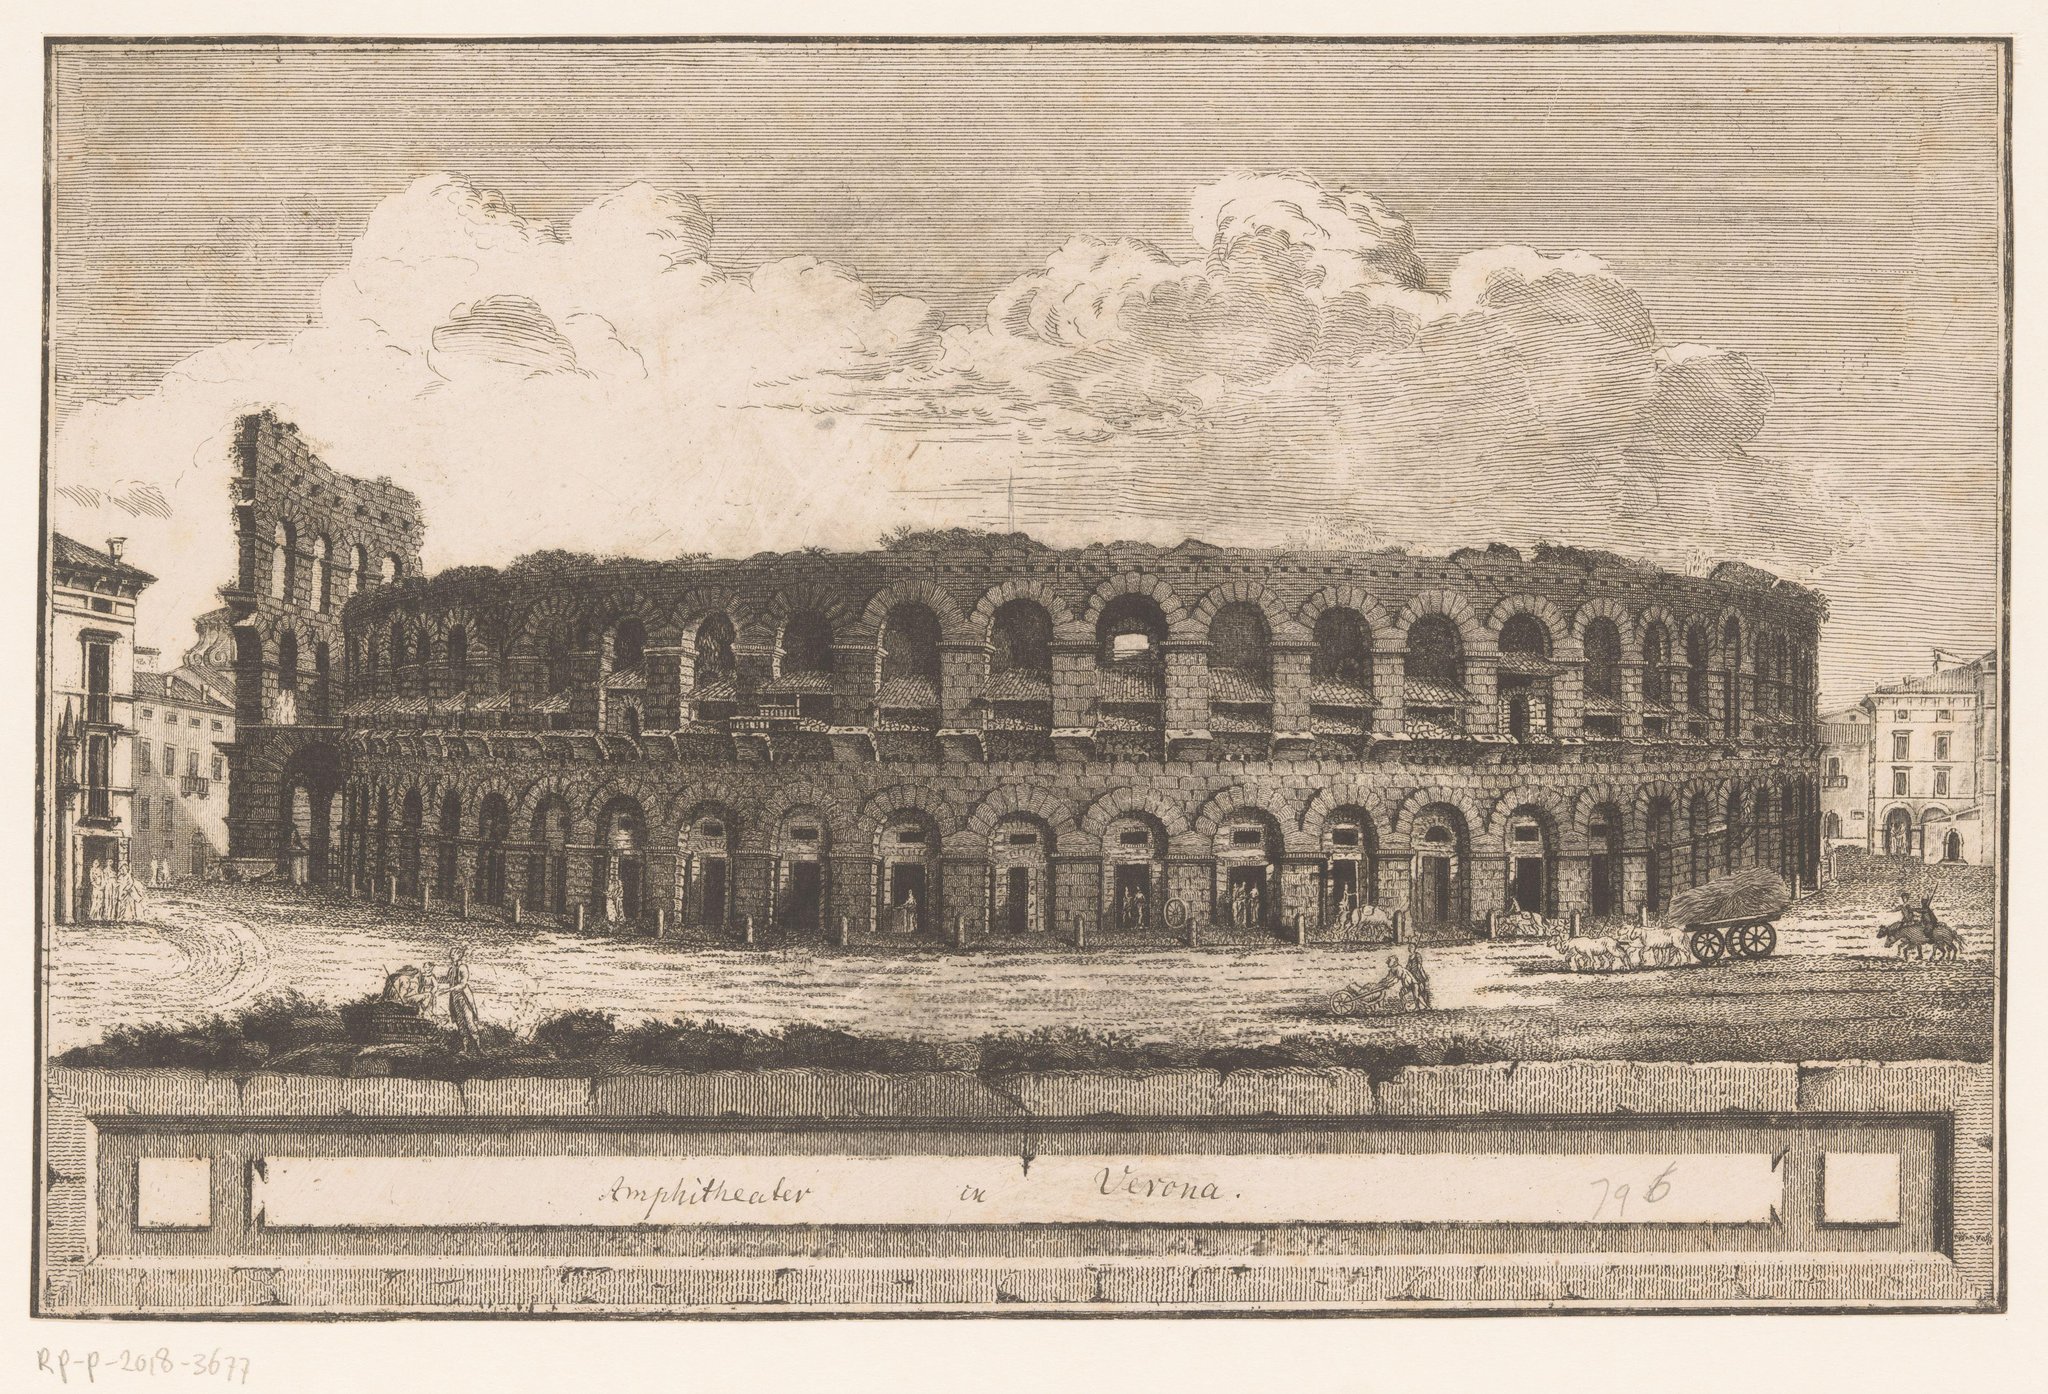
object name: print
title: Amphitheater in Verona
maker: Anonymous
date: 1700-1750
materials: paper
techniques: etching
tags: amphitheatre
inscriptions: inscription: ‘Amphitheater in Verona’, collector's mark: Lugt 2228